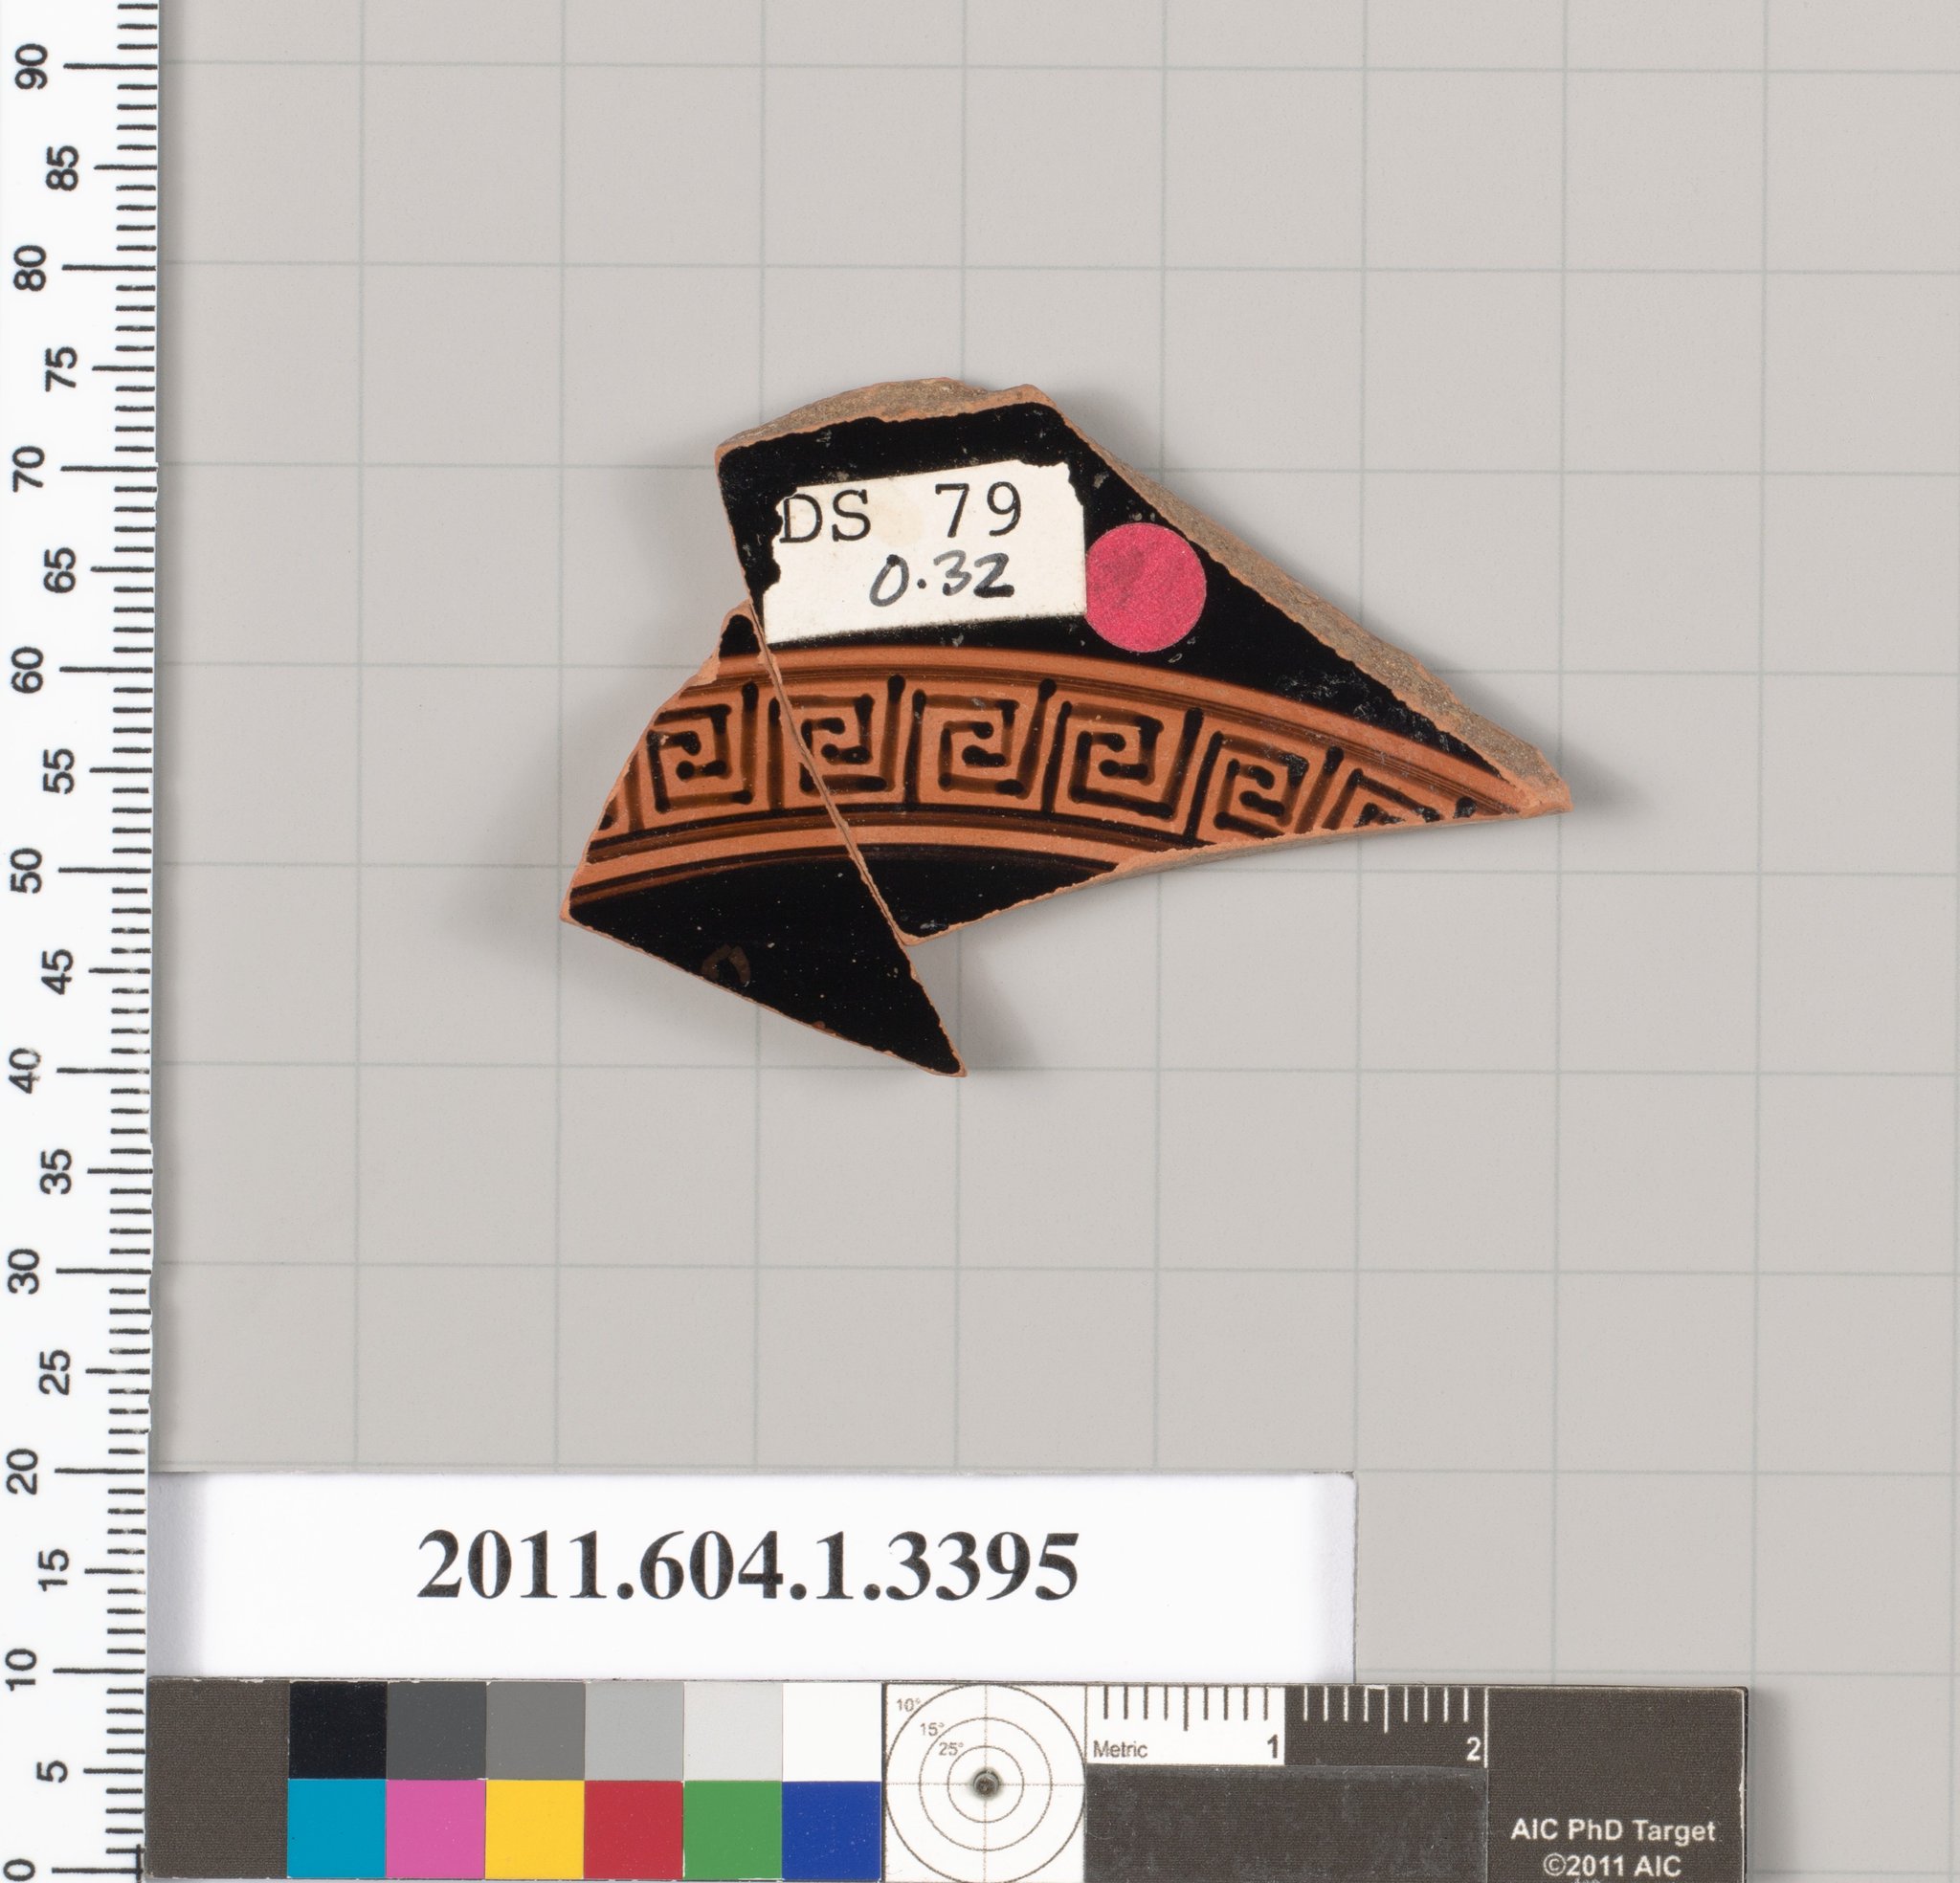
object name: kylix fragment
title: Terracotta fragment of a kylix (drinking cup)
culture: greek, attic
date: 500-470 BCE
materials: terracotta